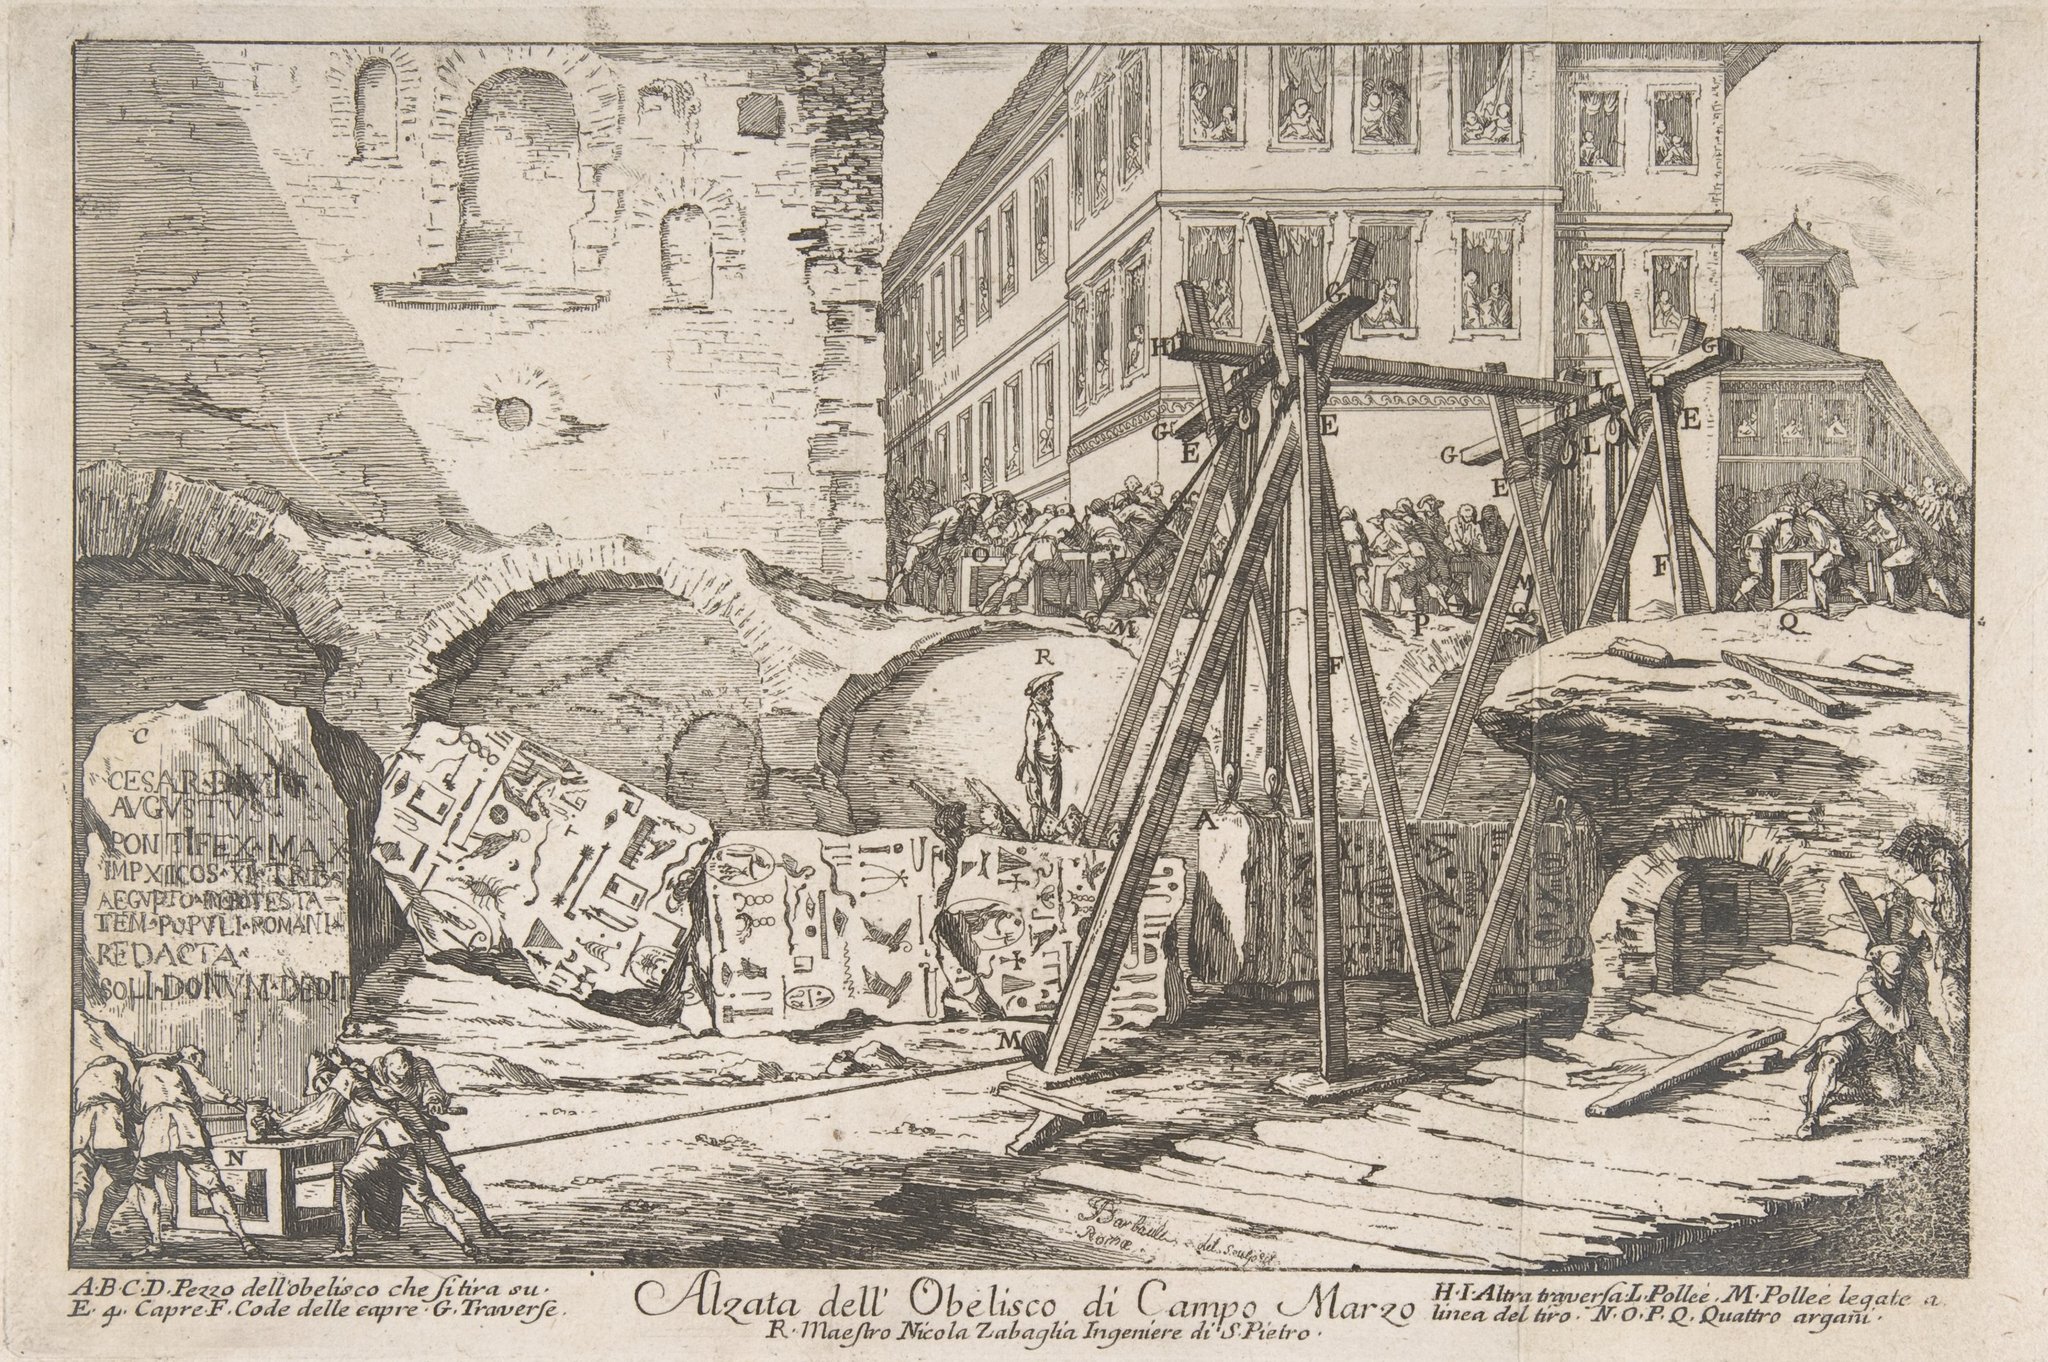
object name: print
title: The Excavation of an Obelisk from the Campo Marzo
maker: jean barbault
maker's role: artist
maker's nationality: french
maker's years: 1718-1762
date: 1749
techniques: etching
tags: obelisks,men,hieroglyphs,rome